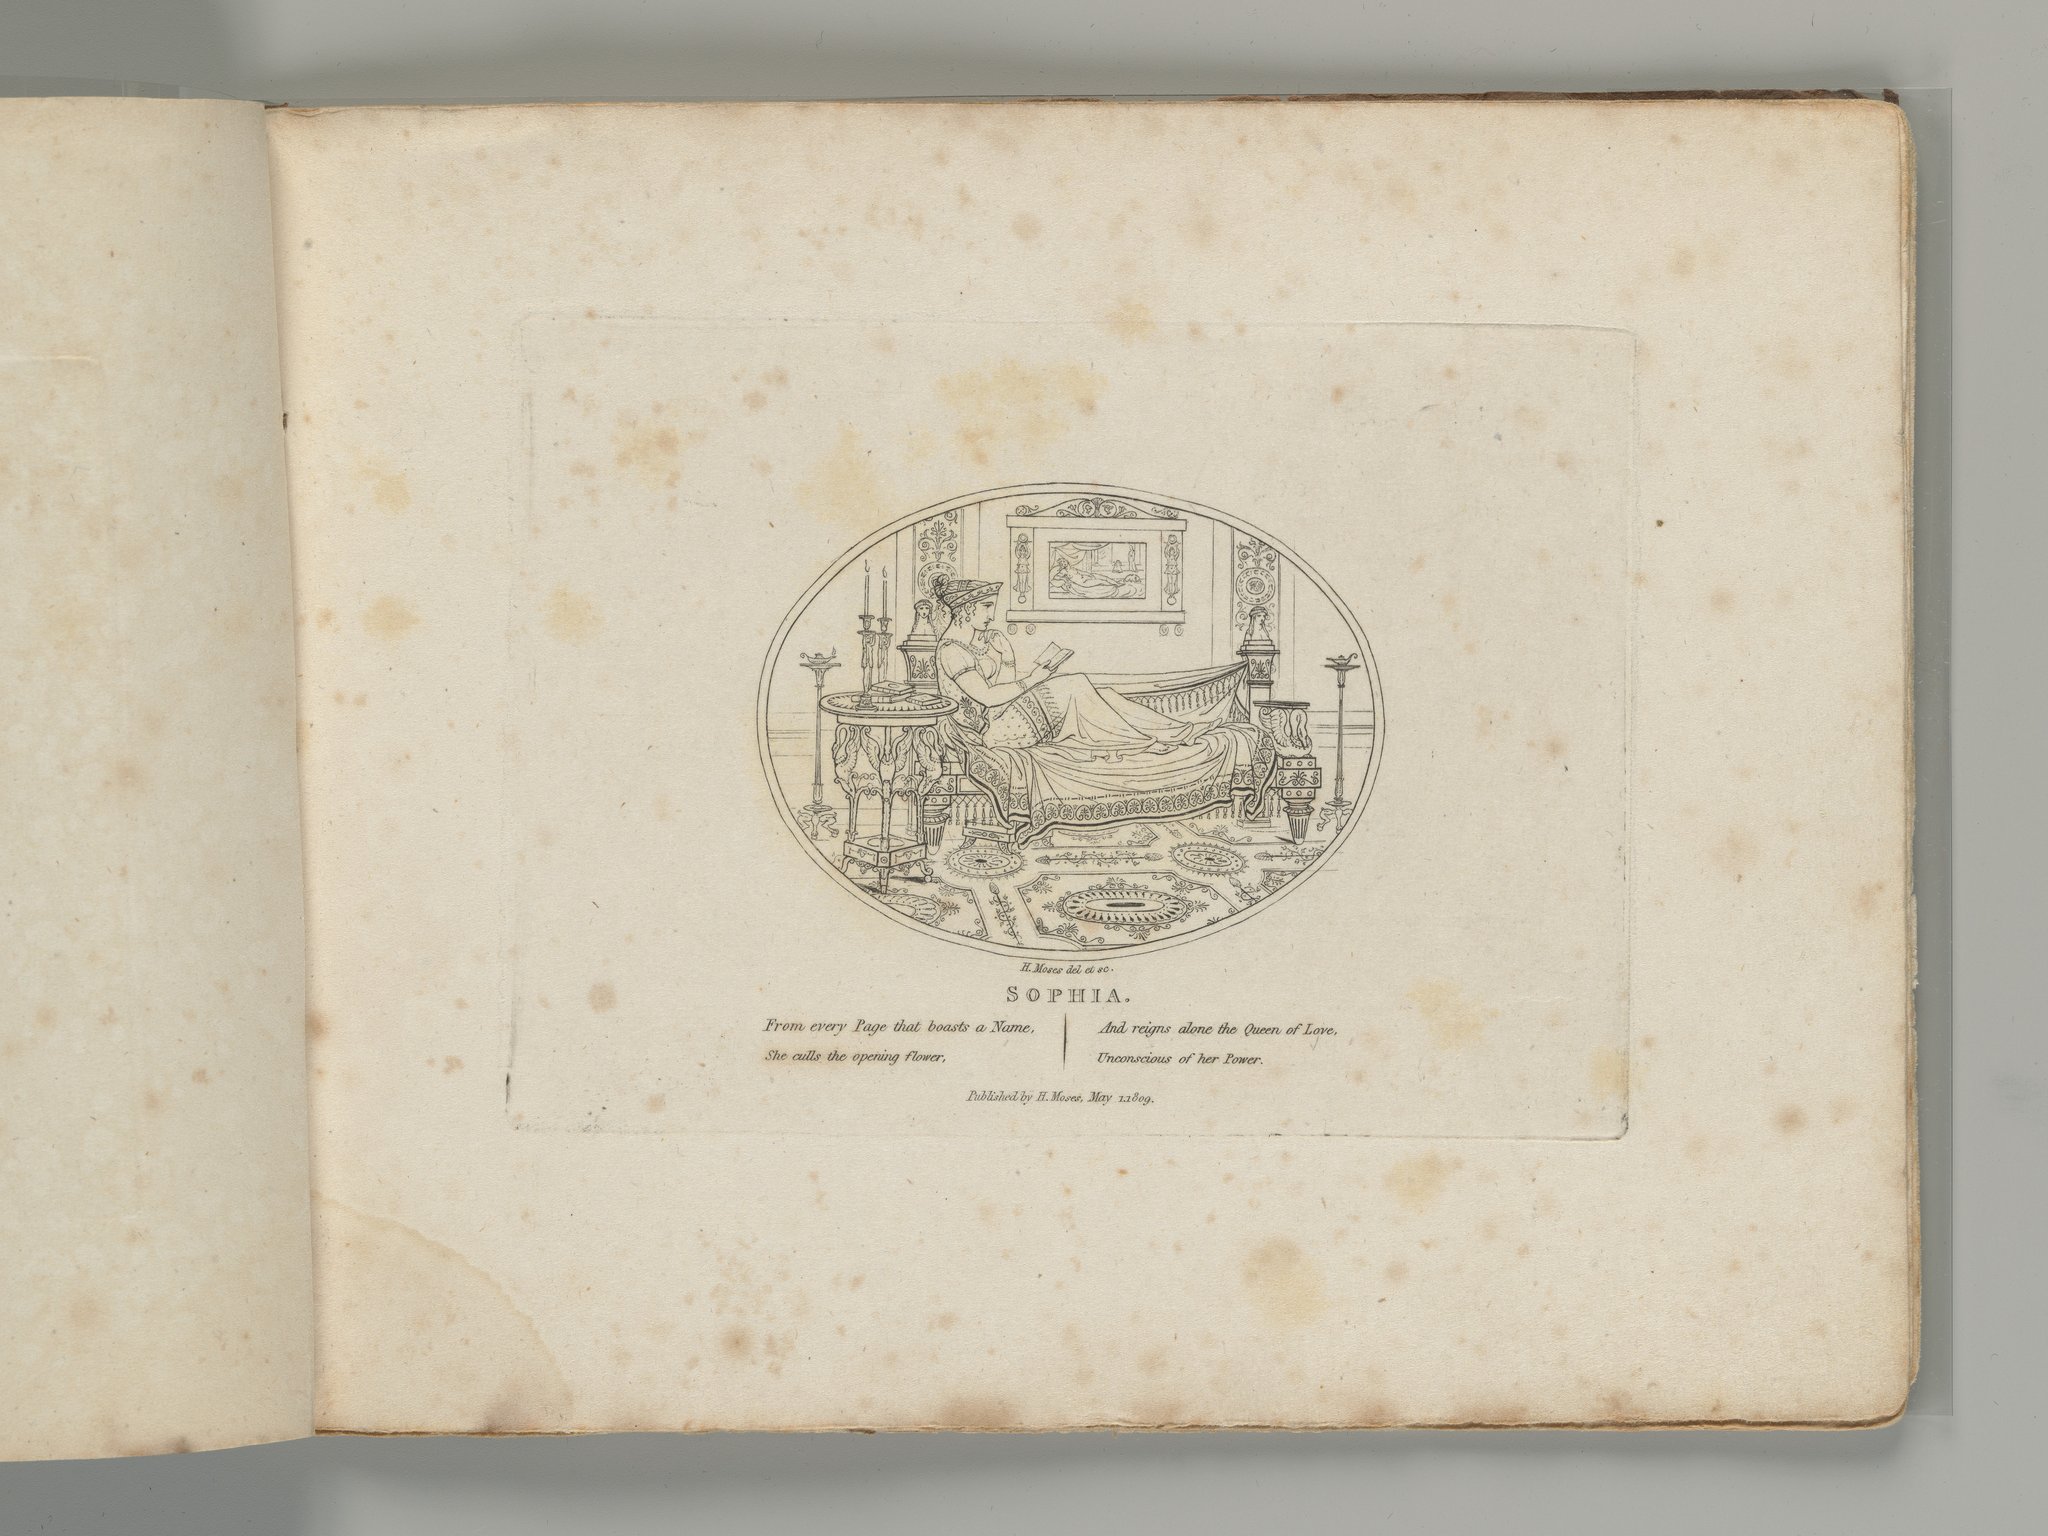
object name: print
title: Sophia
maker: henry moses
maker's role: artist and publisher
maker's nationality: british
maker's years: 1780-1870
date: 1809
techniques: engraving, etching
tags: women,reading,couches